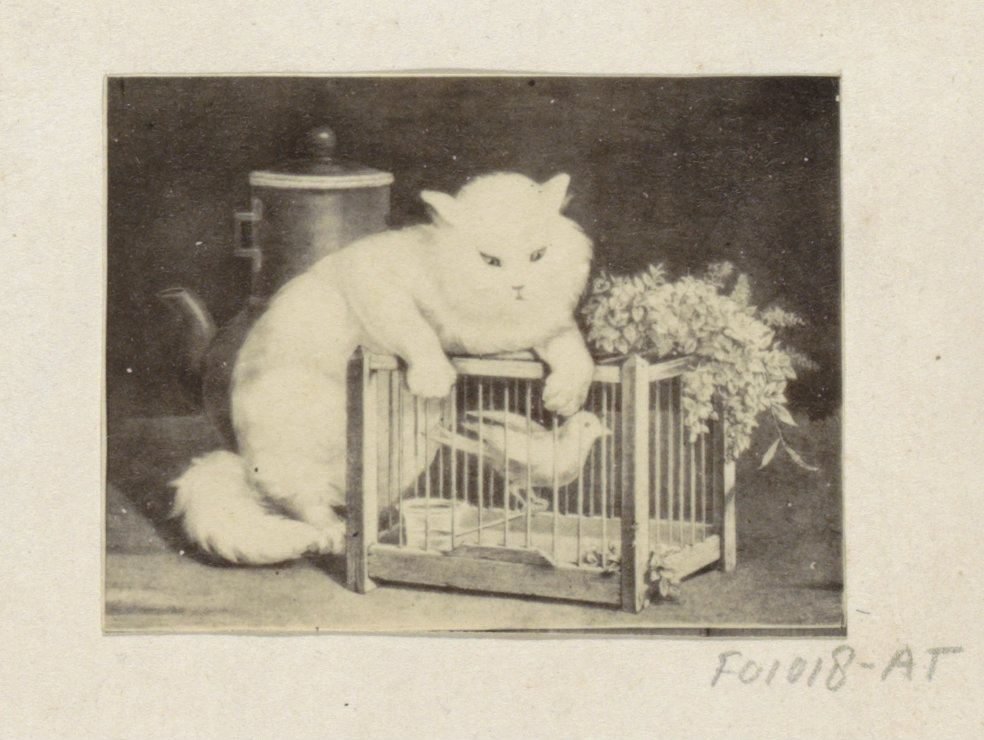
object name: photograph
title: Fotoreproductie van (vermoedelijk) een schilderij met een kat bij een vogelkooi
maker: Anonymous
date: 1860-1870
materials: paper, photographic support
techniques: albumen print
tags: cat, bird in a cage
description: Onderdeel van Engels familiealbum met foto's van personen, reizen, cricket en kunstwerken.